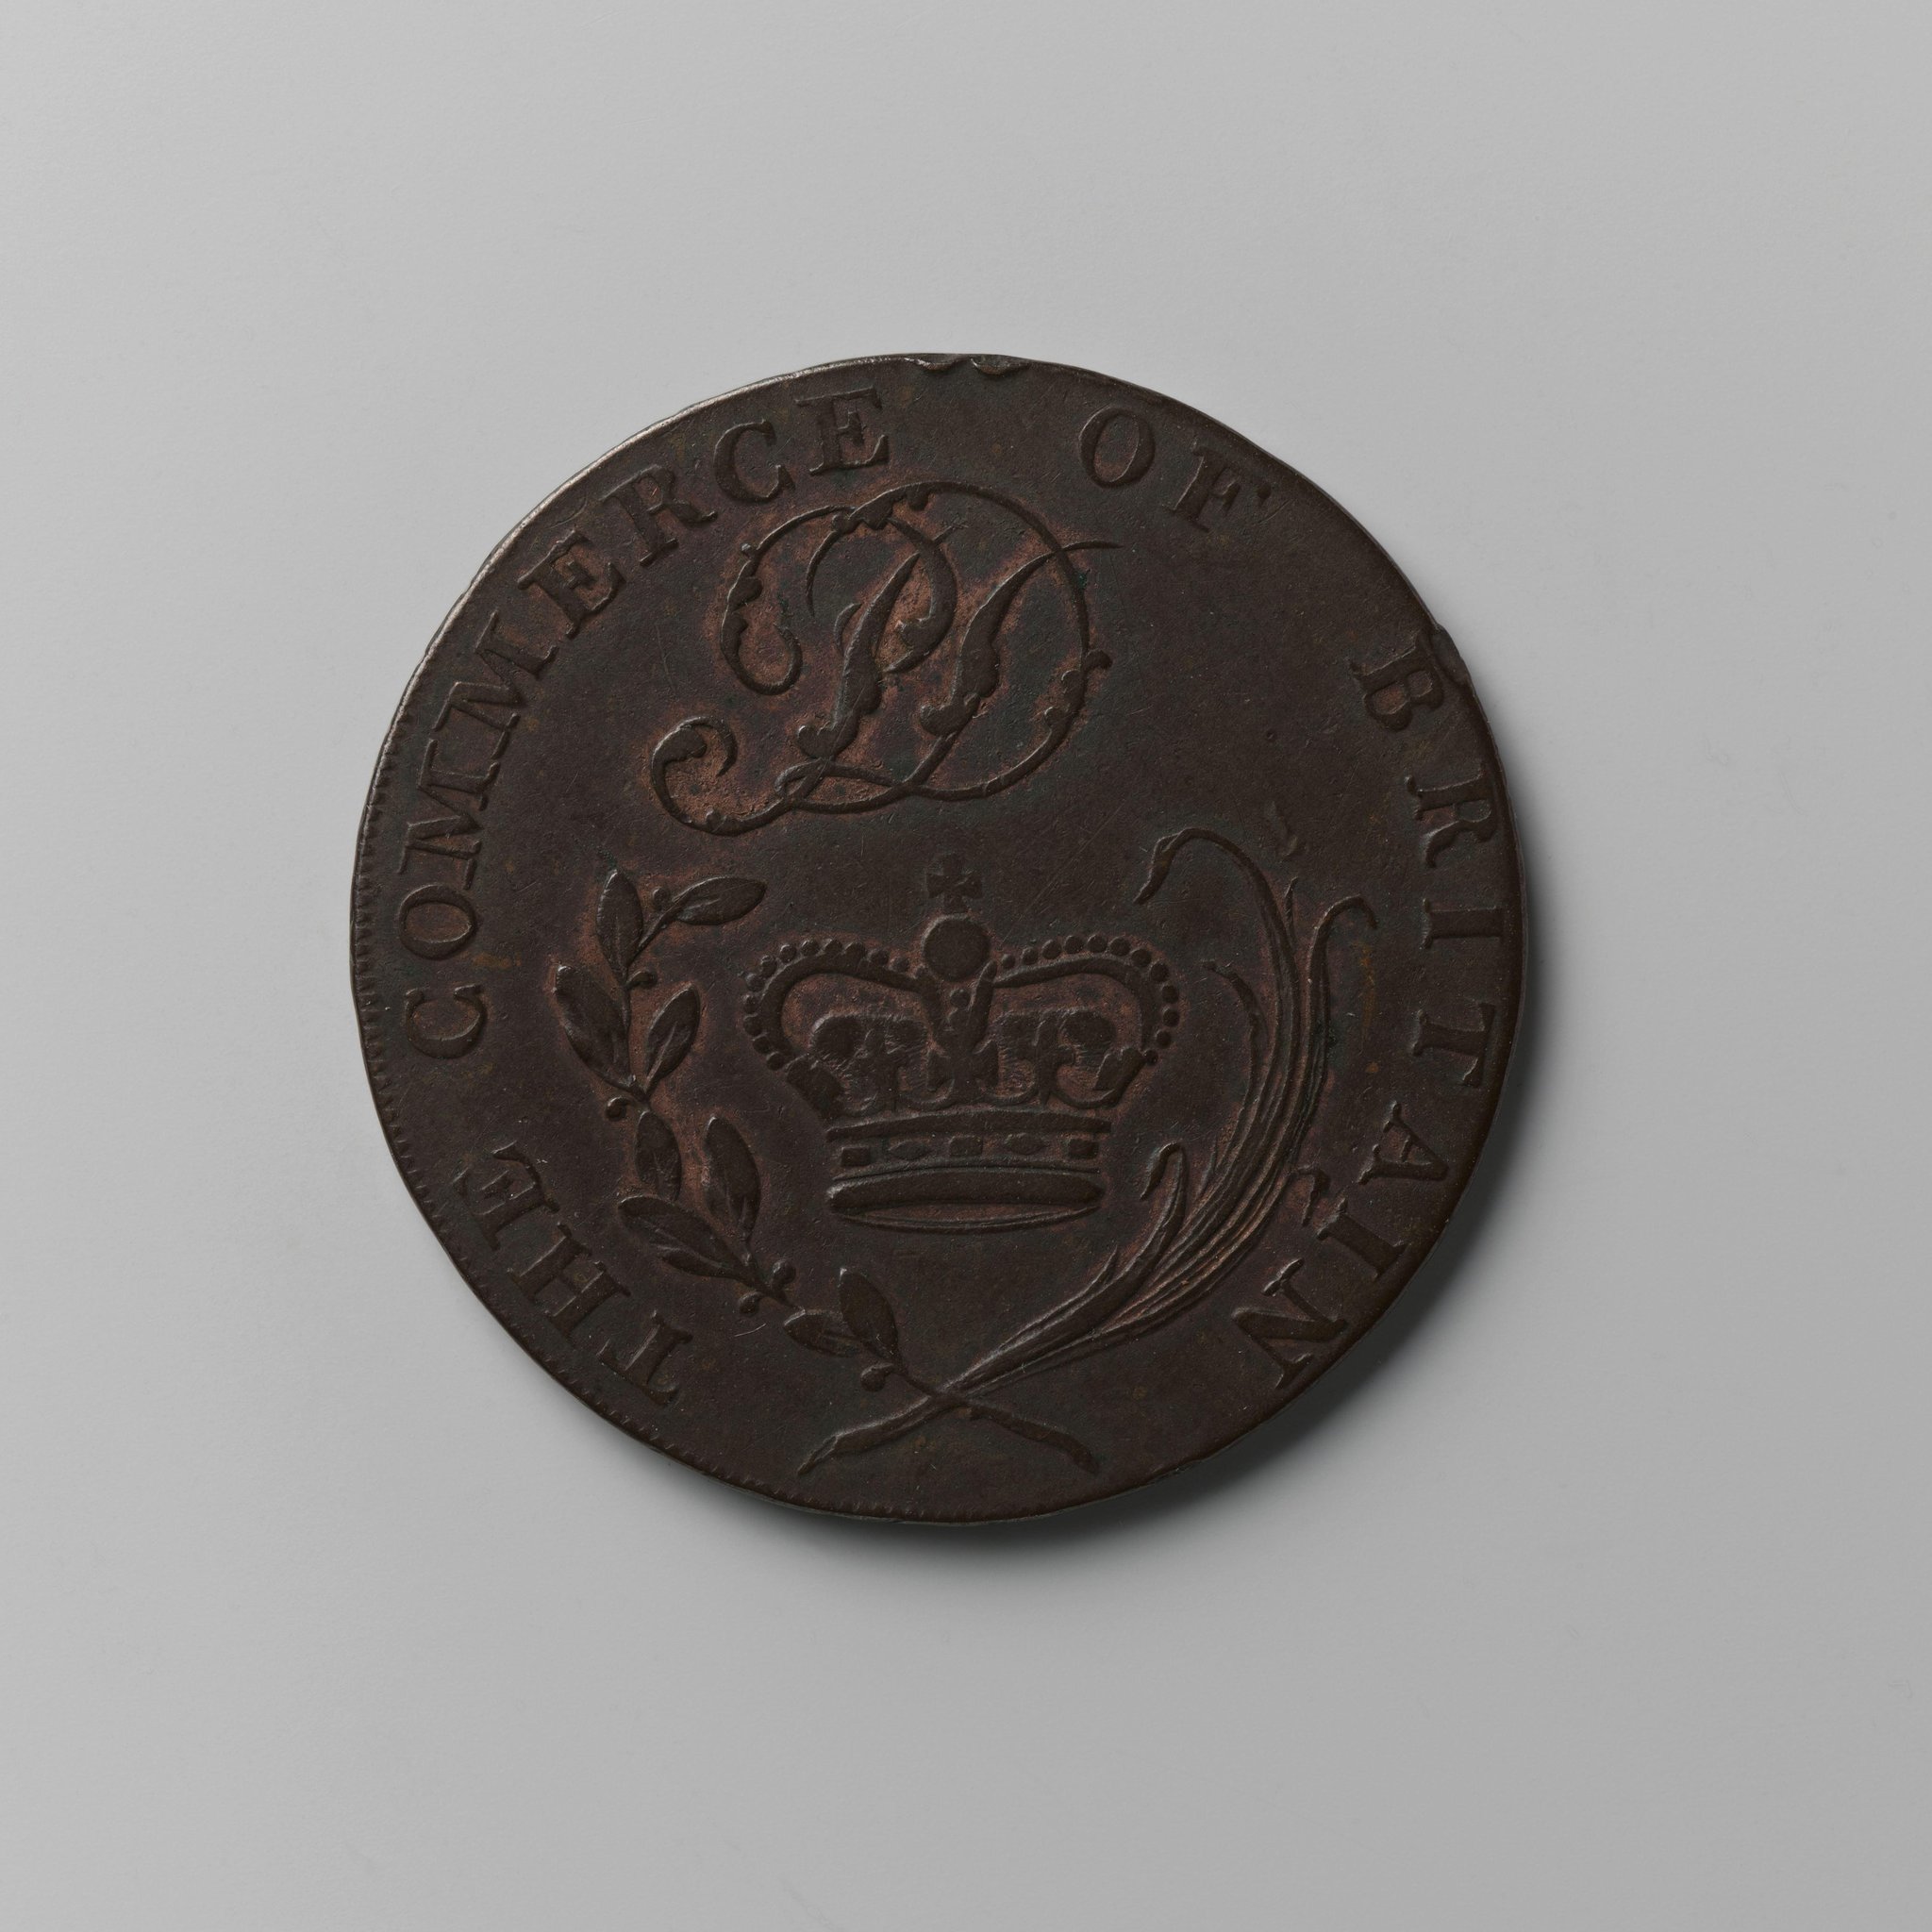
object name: monetary token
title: Halve penny-token, Bury St. Edmunds, Engeland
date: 1790-1817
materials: copper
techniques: striking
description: Koperen particuliere munt. Voorzijde: wapenschild, waarboven helmteken. Keerzijde: tussen twee samengebonden takken kroon, waarboven monogram. Randschrift.